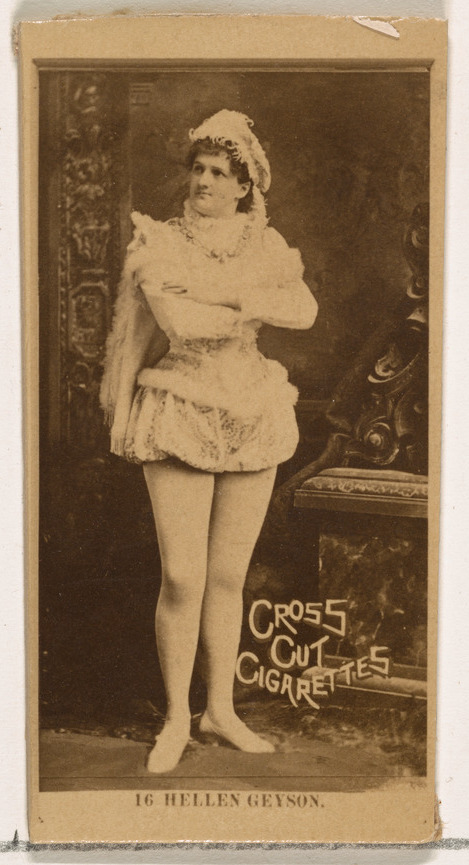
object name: print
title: Card Number 16, Hellen Geyson, from the Actors and Actresses series (N145-2) issued by Duke Sons & Co. to promote Cross Cut Cigarettes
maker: w. duke, sons & co.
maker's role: publisher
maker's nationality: american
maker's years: 1870-1920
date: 1880-1889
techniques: albumen silver print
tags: portraits,women,actresses